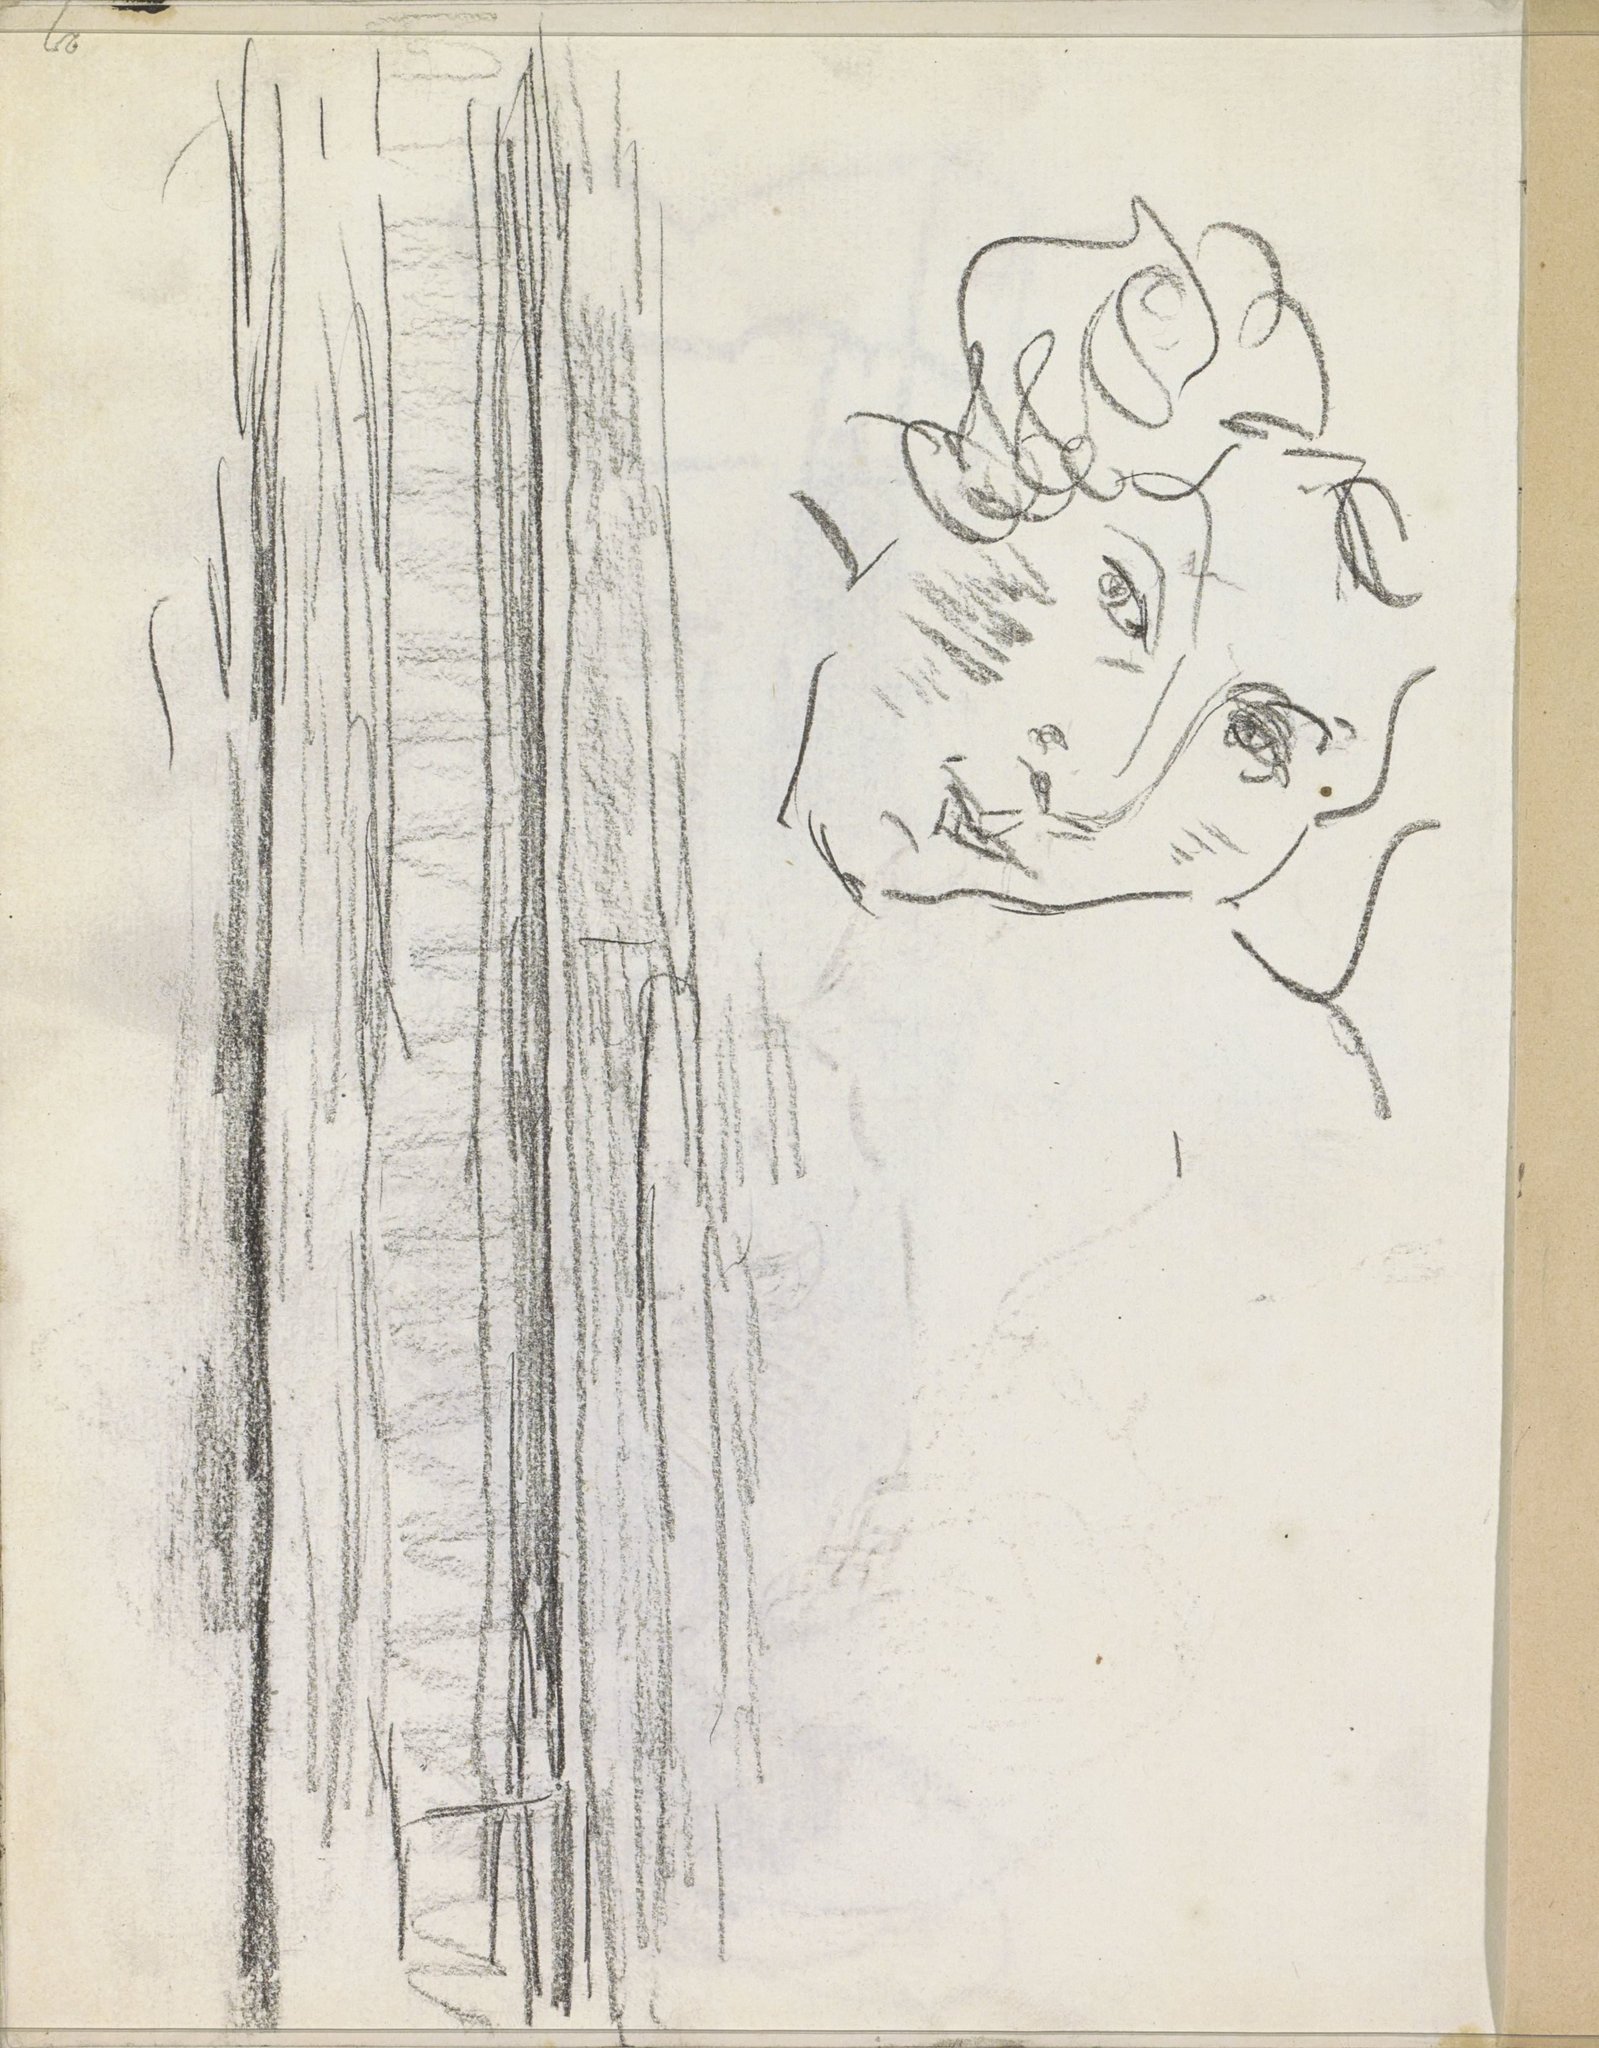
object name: sketchbook leaf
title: Vrouwenhoofd en mogelijk een landschap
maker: isaac israels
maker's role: draughtsman, painter, print maker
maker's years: 1865-1934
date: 1875-1934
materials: chalk, paper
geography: the hague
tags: landscapes in the temperate zone, head (human) - aa - female human figure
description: Blad 24 verso uit schetsboek XIII met 25 bladen.